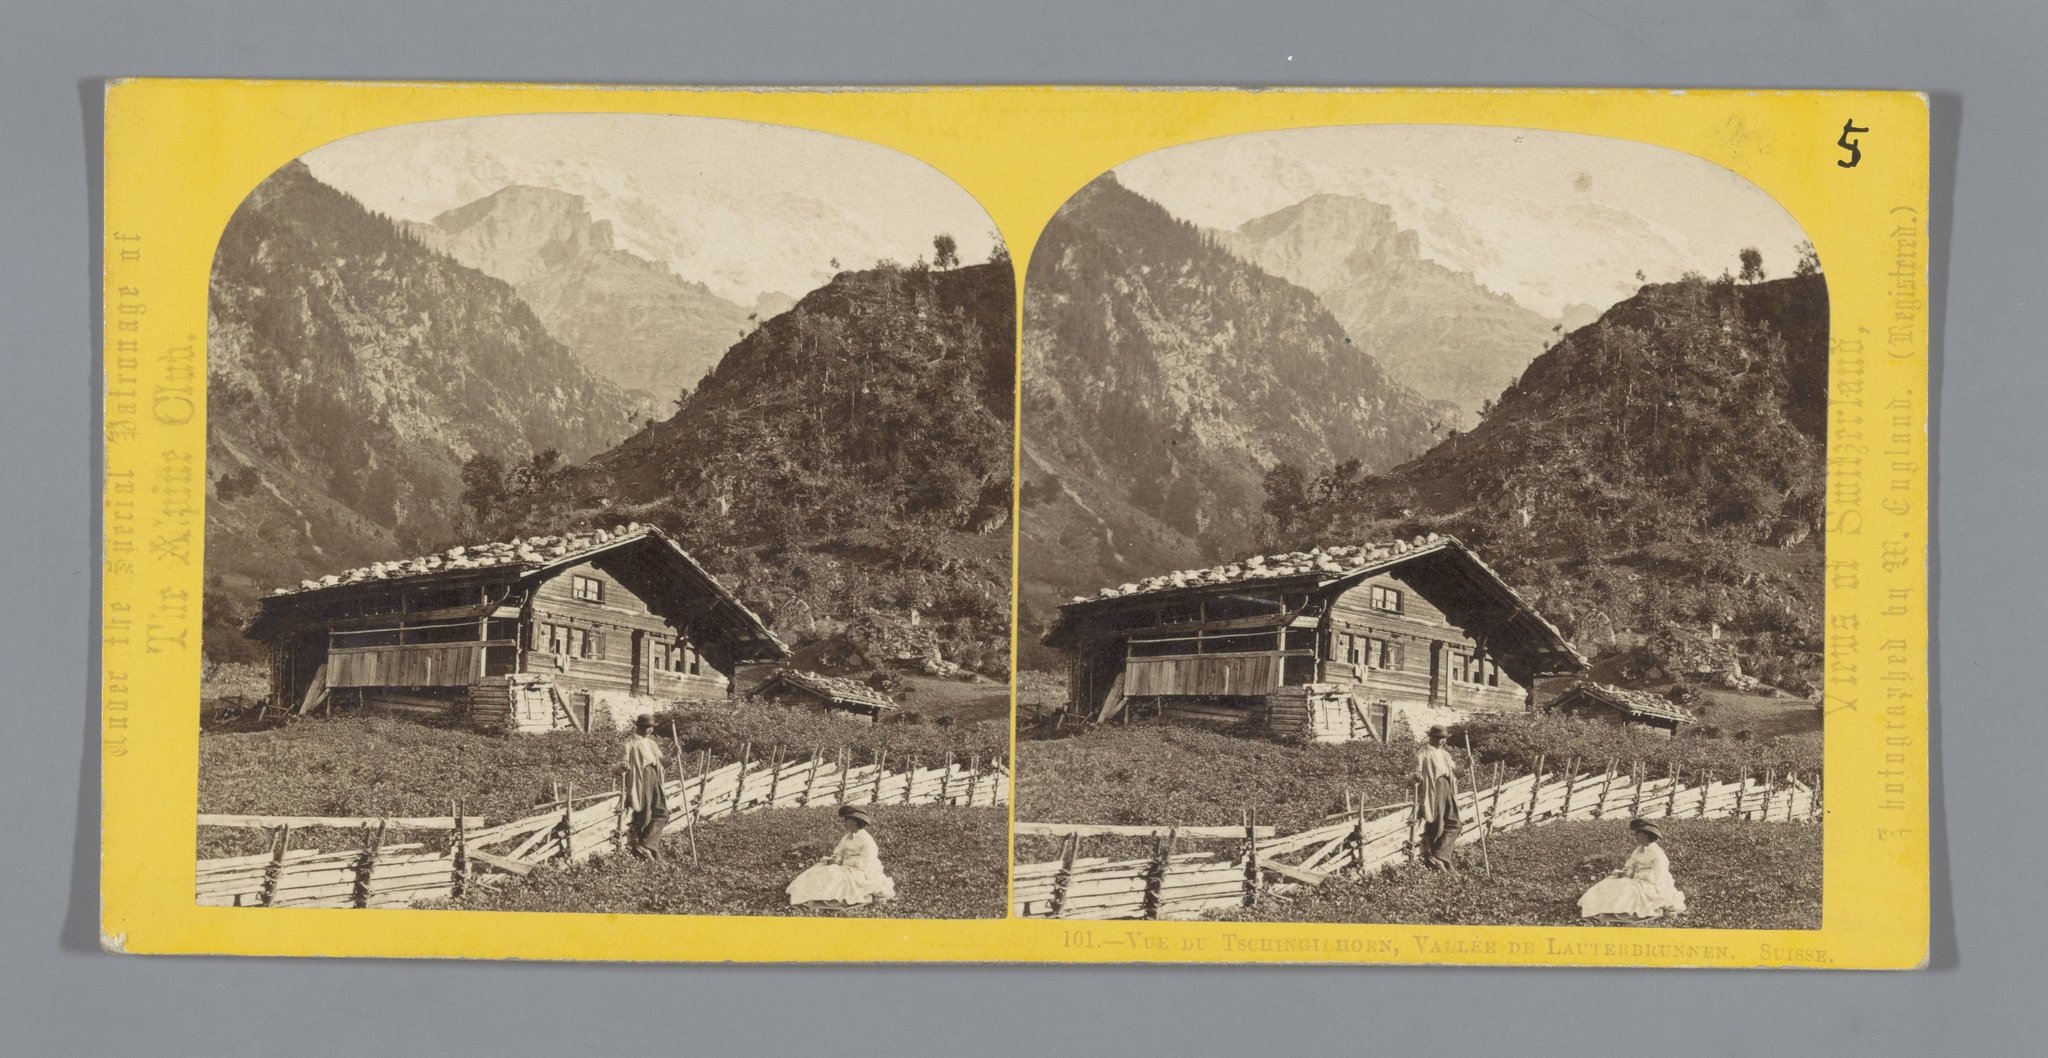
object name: stereograph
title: Vue du Tschingilhorn, Vallée de Lauterbrunnen. Suisse.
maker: william england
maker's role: fotograaf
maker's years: 1816-1896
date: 1850-1880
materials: cardboard, photographic support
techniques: albumen print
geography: bern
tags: mountain-top, peak, façade (of house or building)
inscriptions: number: ‘101.’, inscription: ‘Views of Switzerland, photographed by W. England. (Registered) Under the Special Patronage of the Alpine Club.’, number: ‘5’